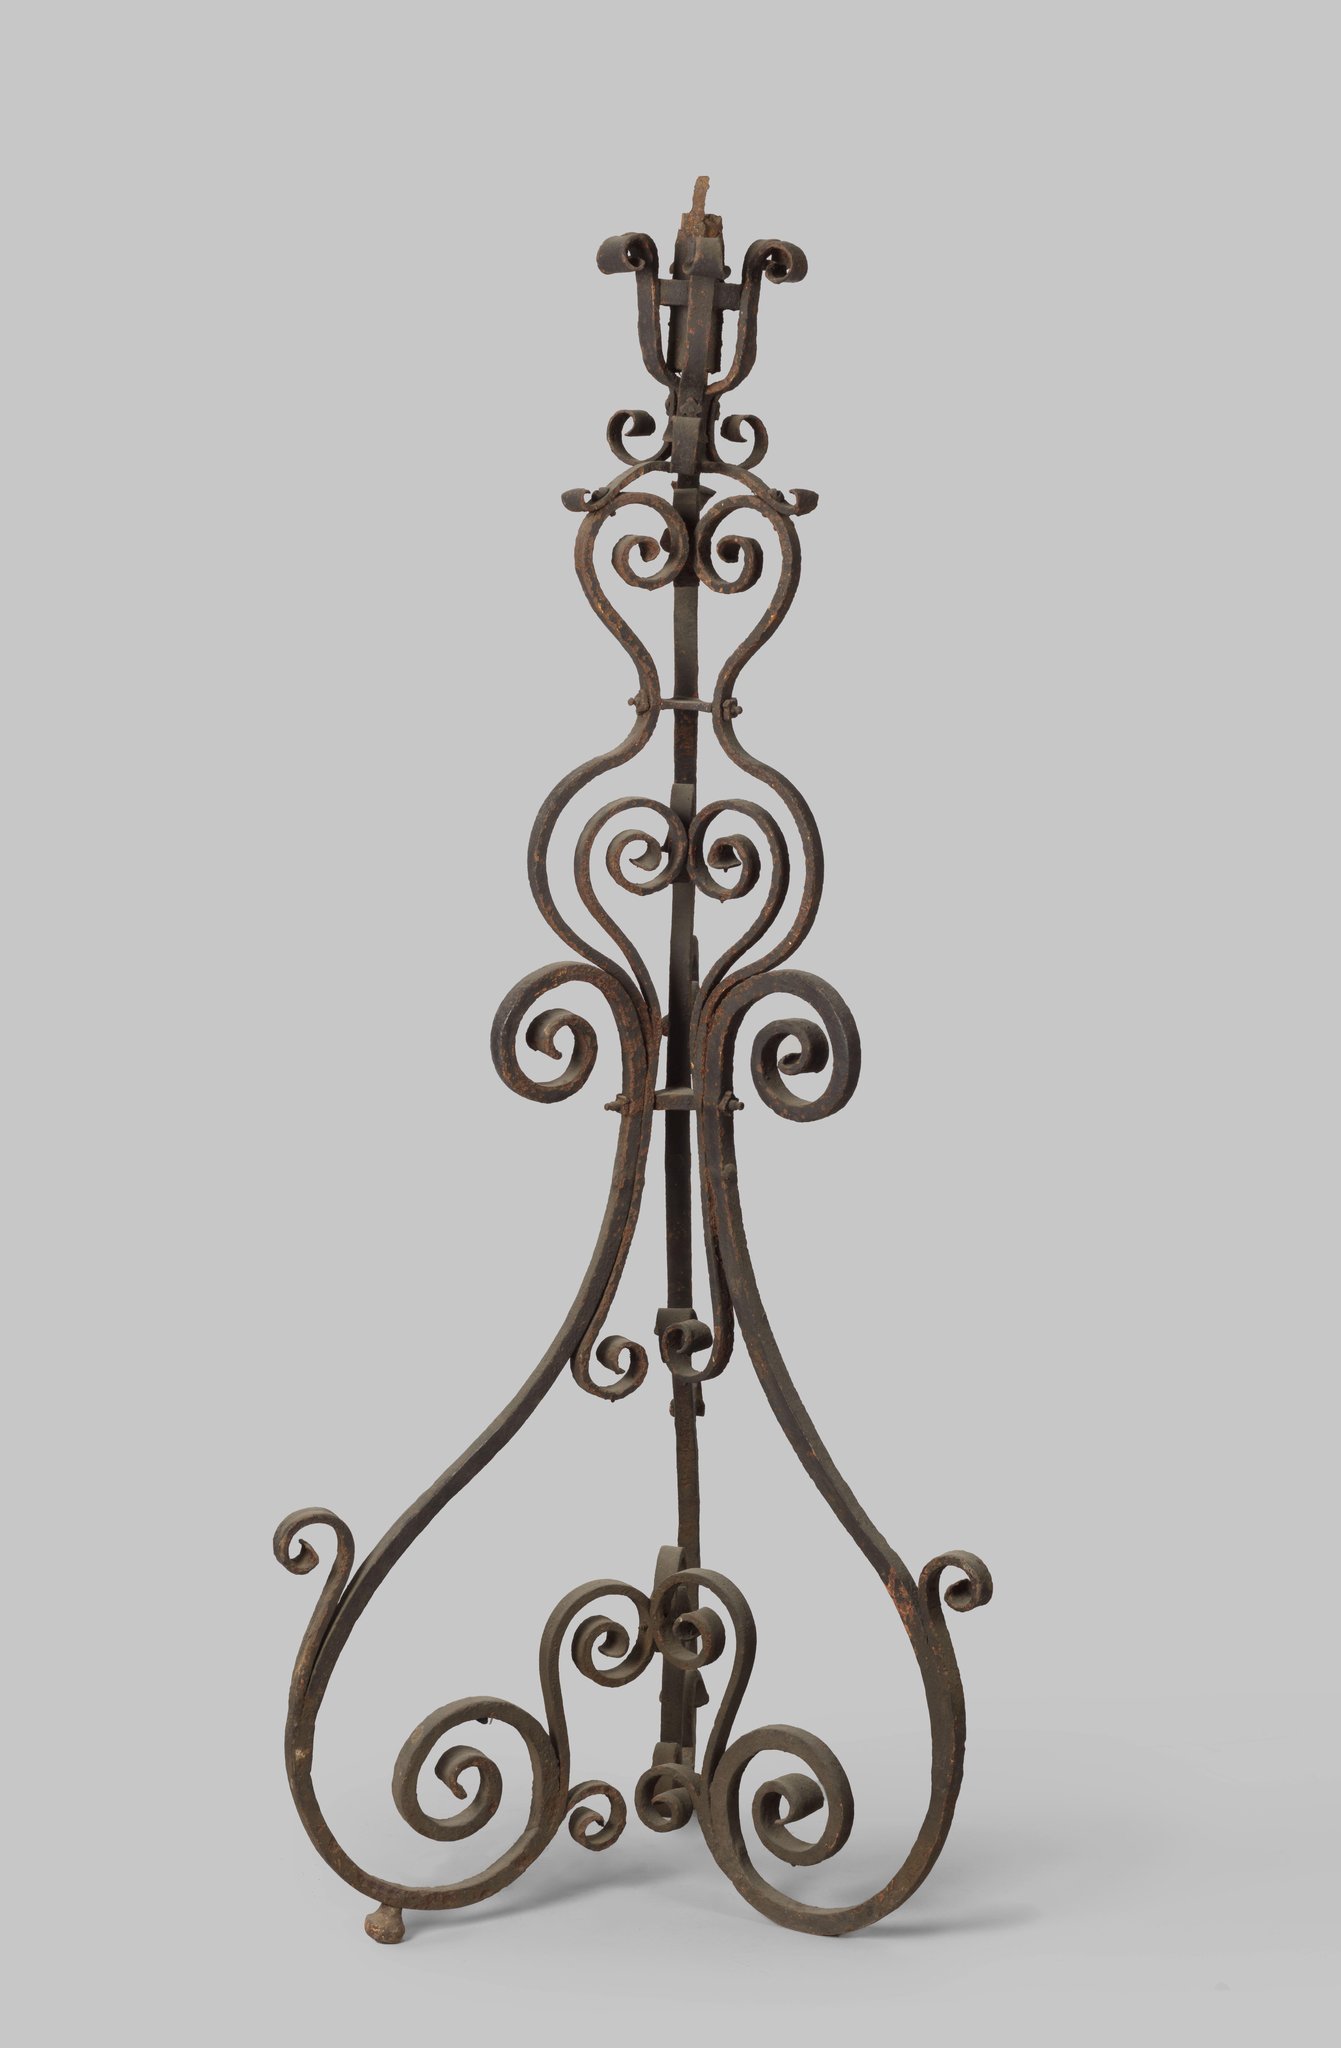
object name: stand support object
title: Standaard van ijzer, met S-voluten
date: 1700-1800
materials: iron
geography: italy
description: Een lantaarn bestaande uit een standaard waarop een lamp. De standaard bestaat uit drie grote S-voluten waarvan de onderste krullen naar binnen toe geplaatst zijn en de bovenste, de kleinere, naar buiten. De lamp is versierd met varenblad; het dak draagt zes schilden. Ijzer en hout. Afkomstig uit de verzameling Dr. F. Mannheimer.